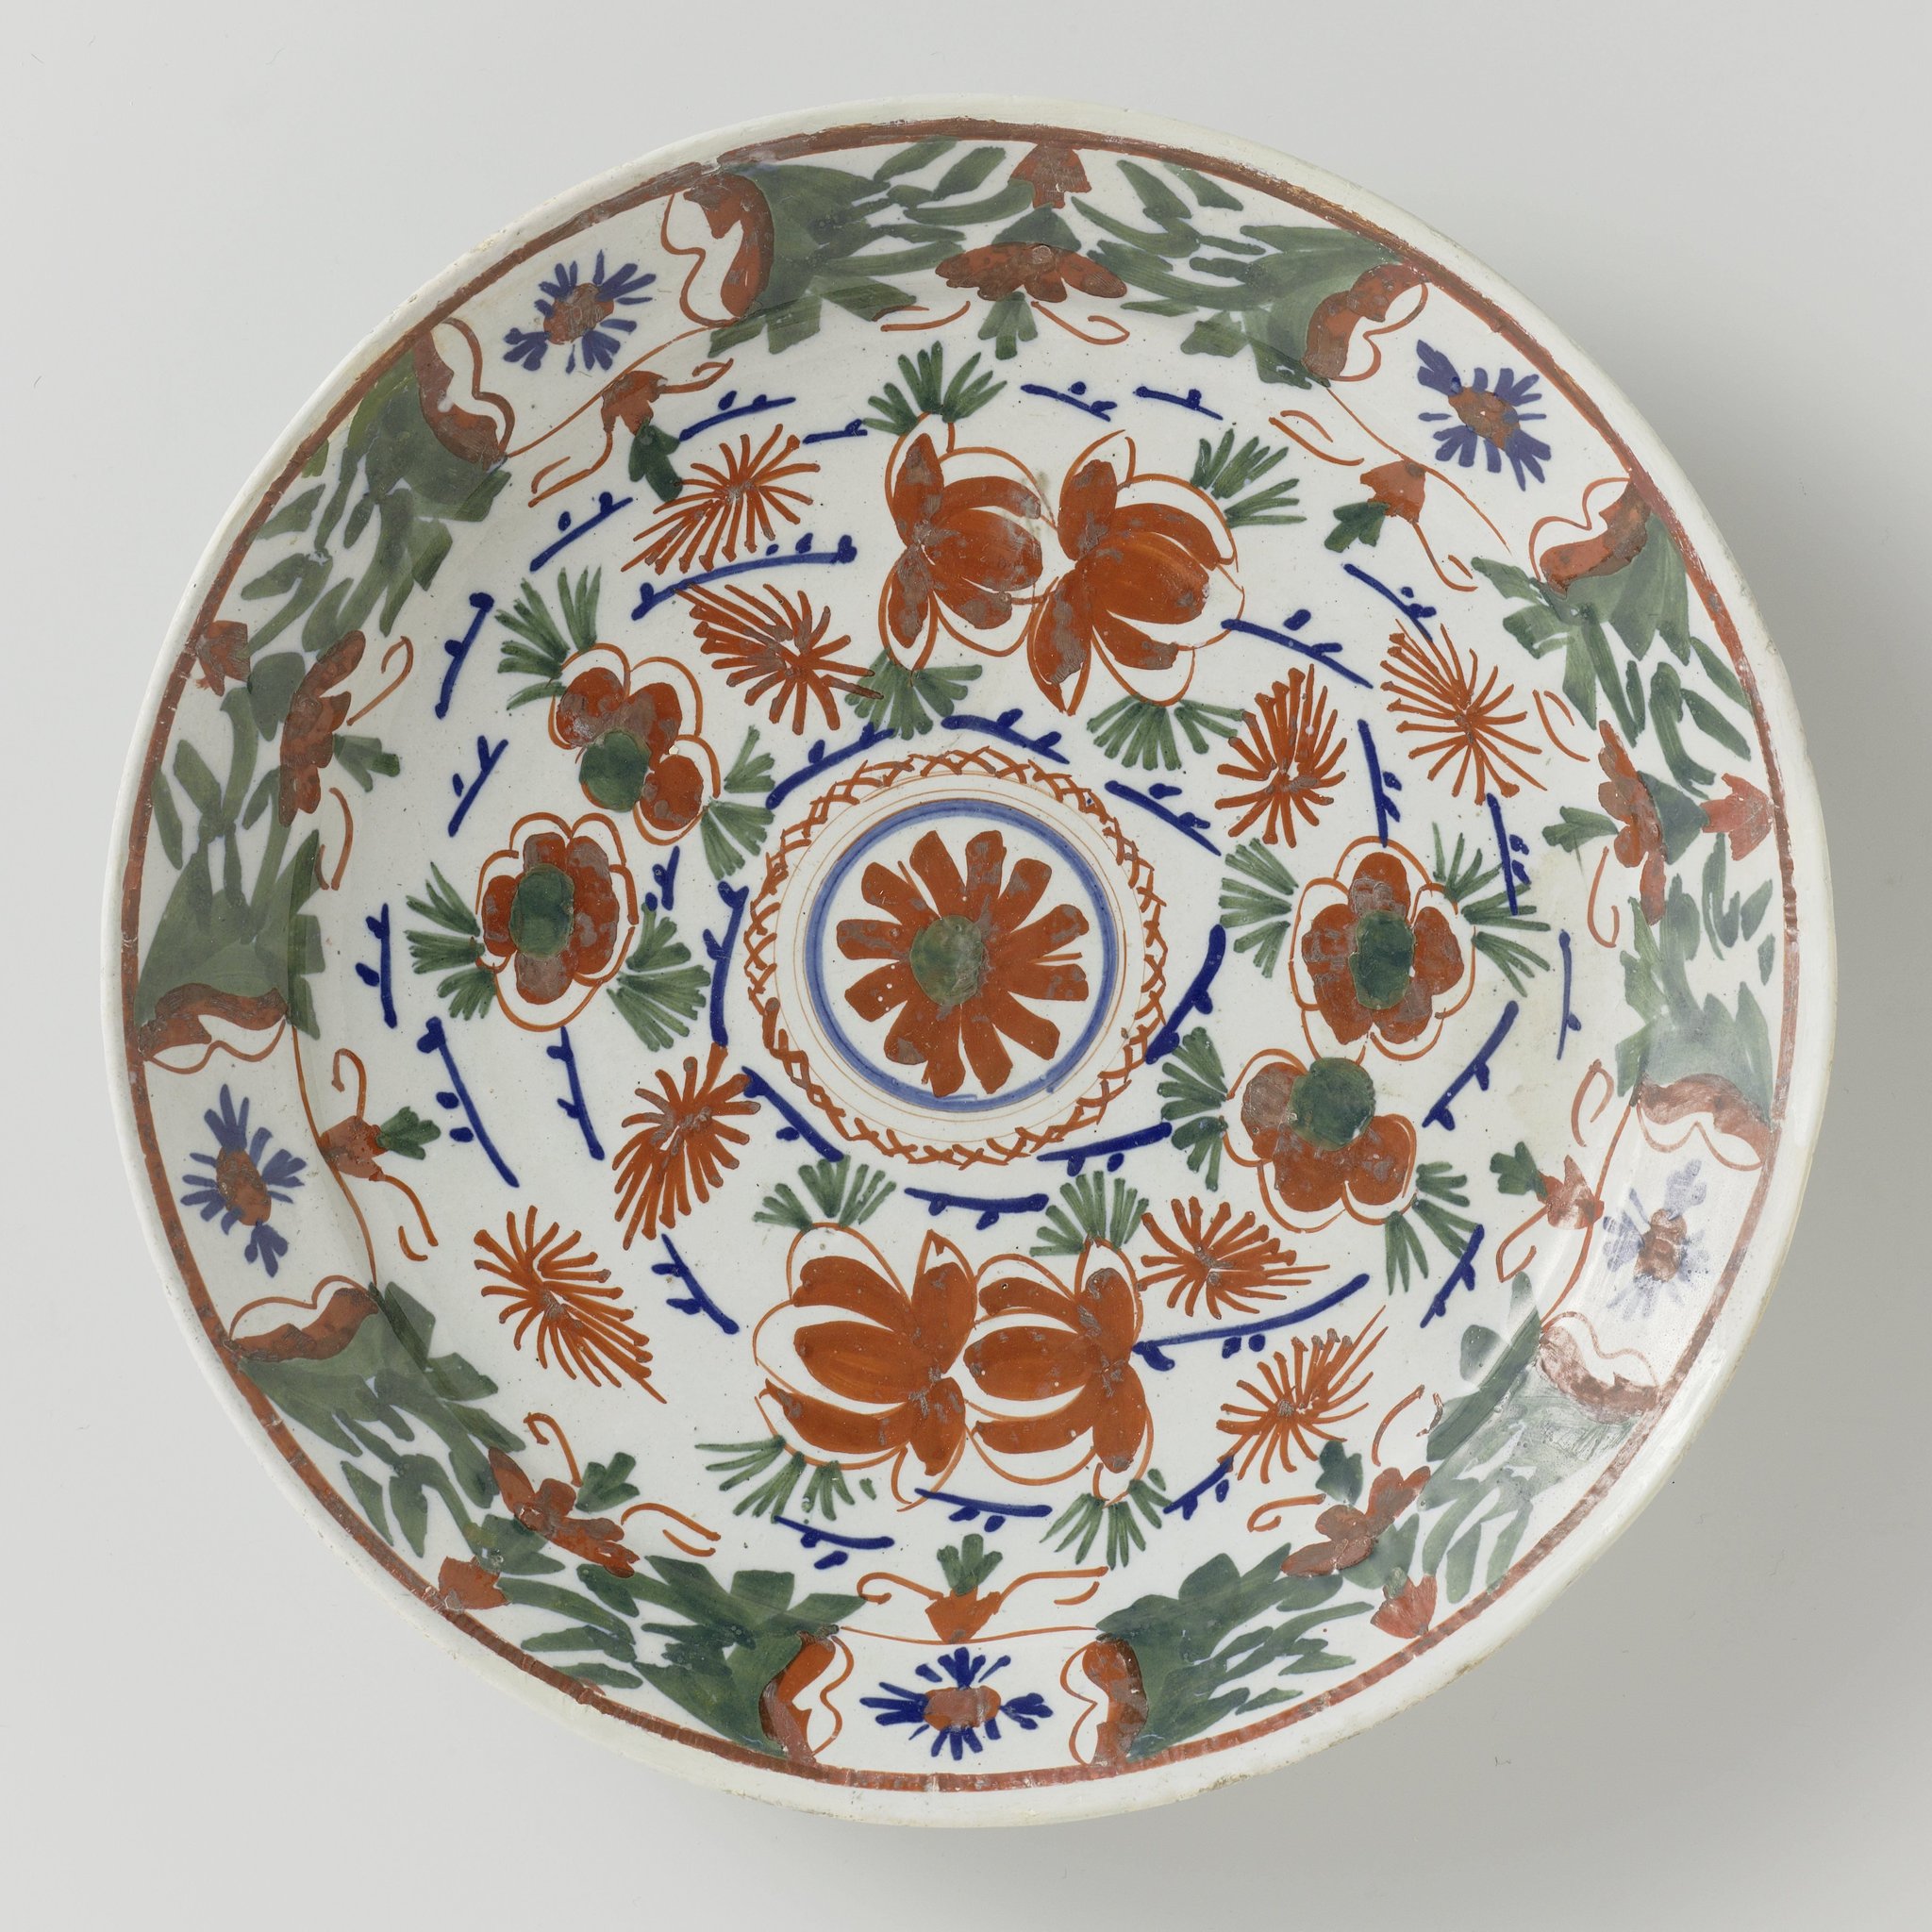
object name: pannenkoekbord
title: Bord van veelkleurig beschilderde faience met bloemdecoratie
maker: Anonymous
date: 1730-1780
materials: earthenware, glaze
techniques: painted, polychromy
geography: delft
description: Rond bord van veelkleurig beschilderde faience, beschilderd met bloemen en bloemmotieven in de kleuren groen, rood en blauw. Bij het bord horen twee identieke borden met invnrs. BK-NM-13351-e en BK-NM-13351-g.